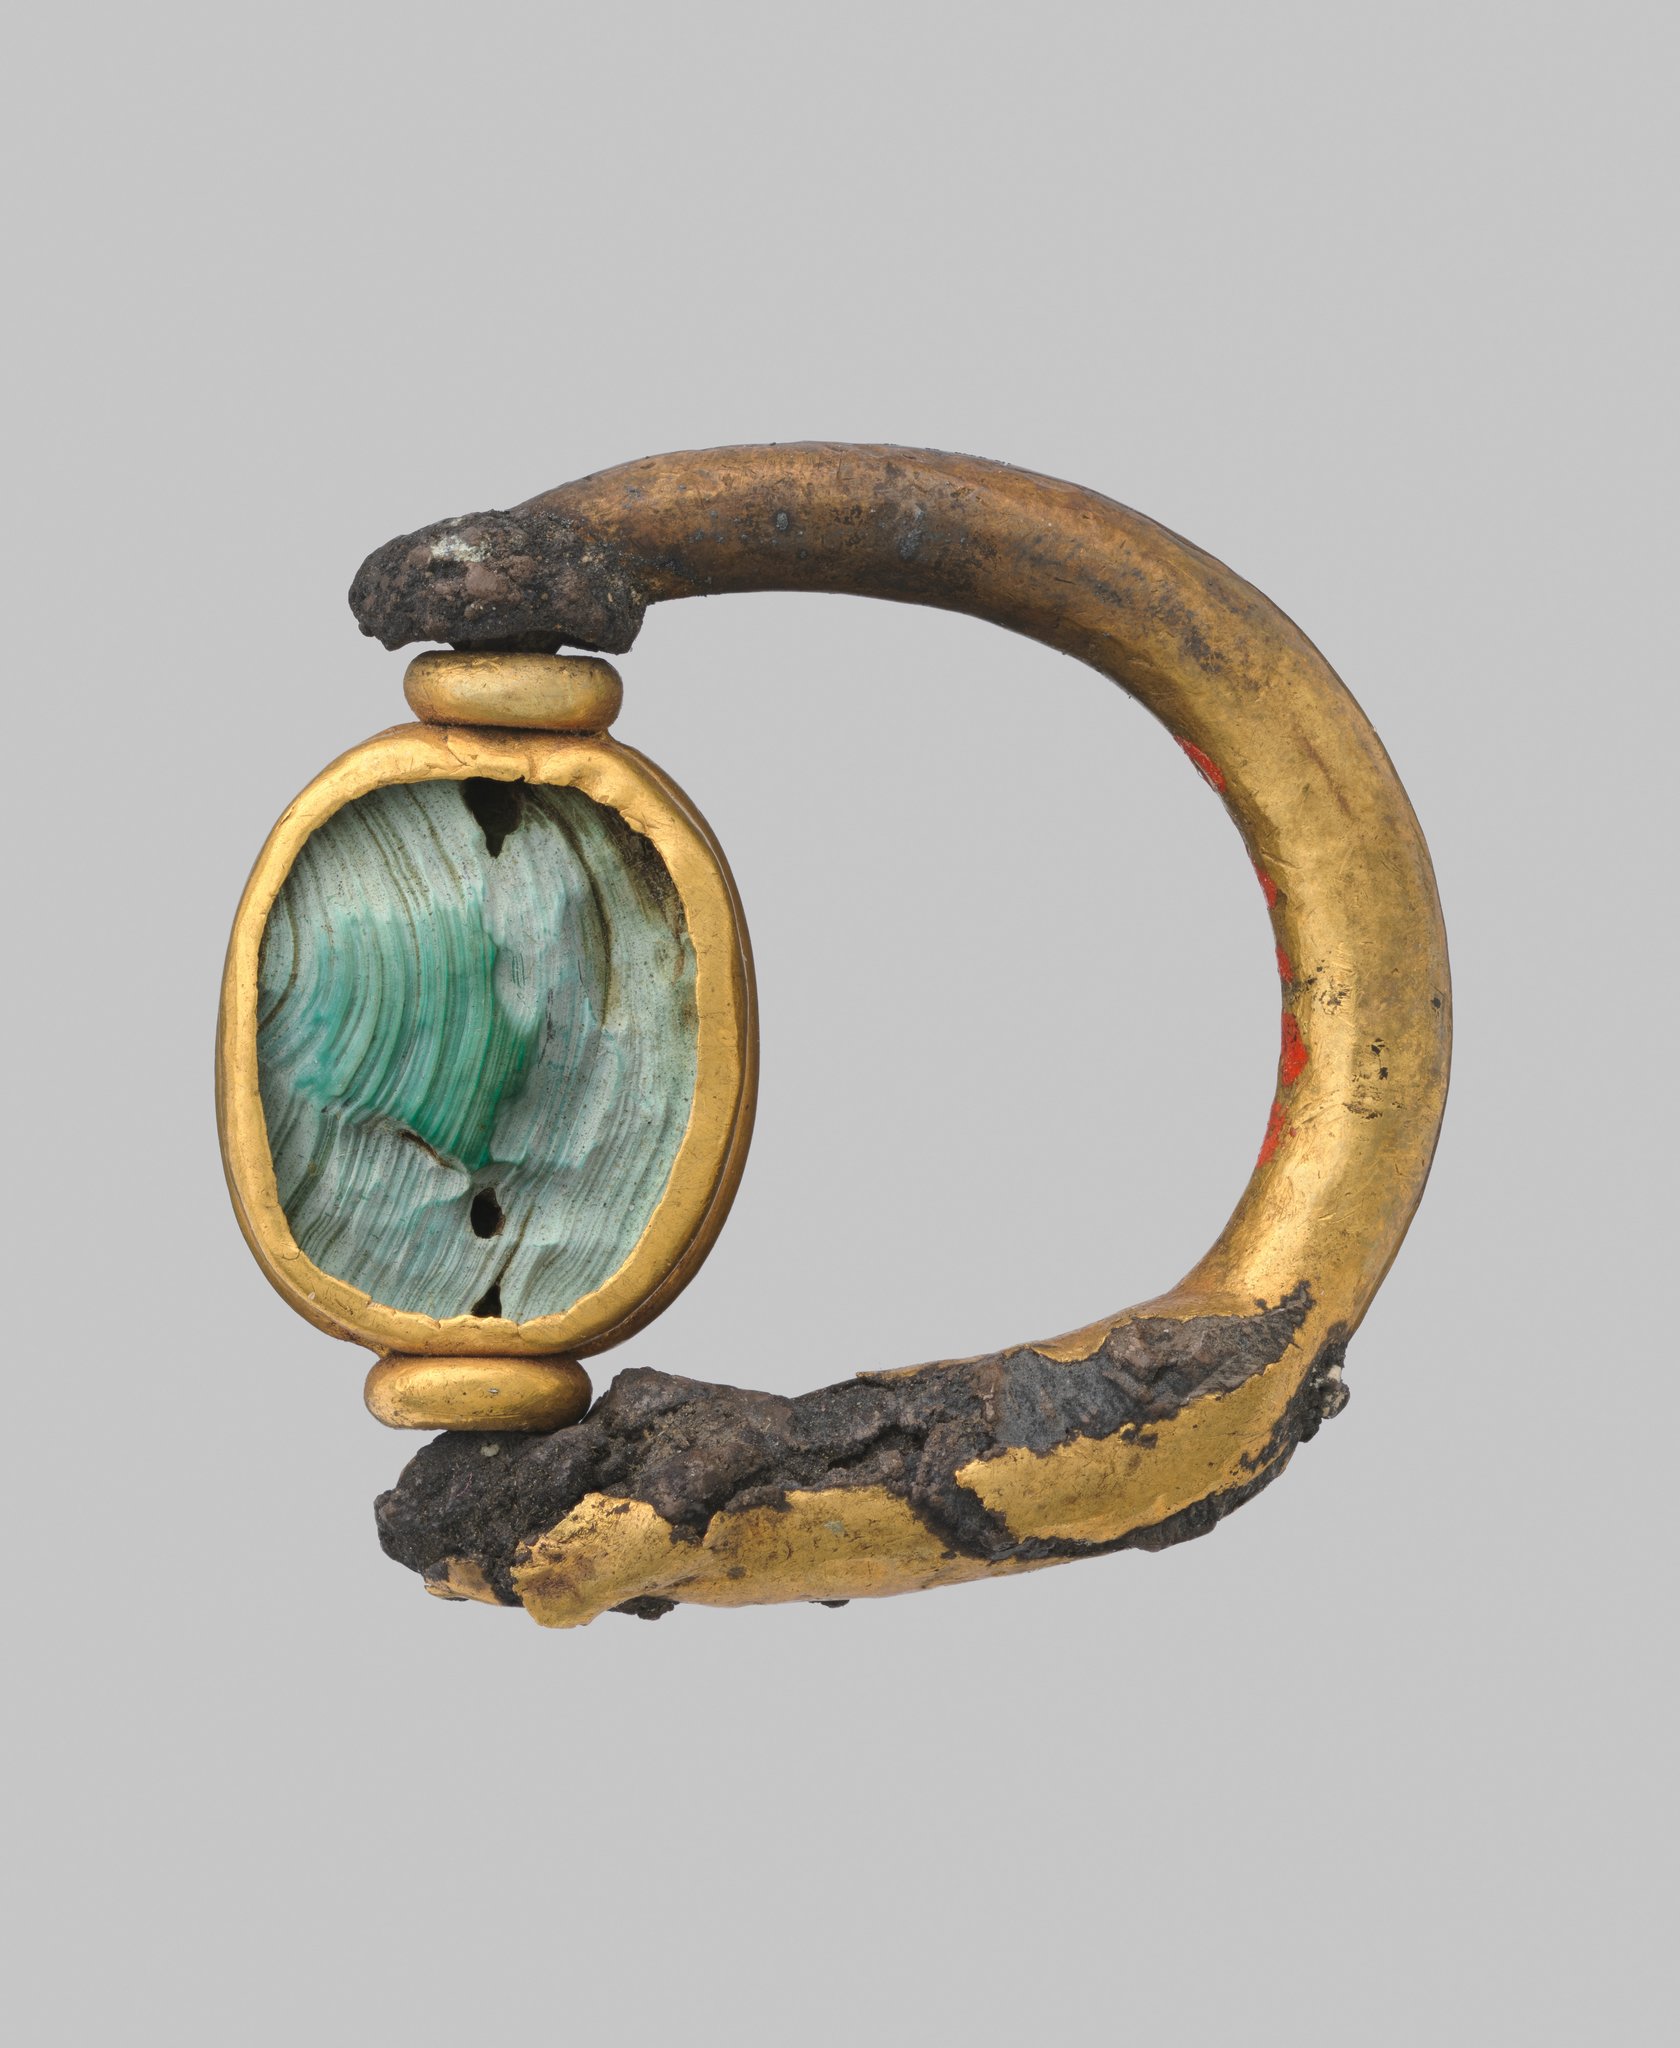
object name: ring with scaraboid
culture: cypriot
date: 700-501 BCE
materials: gold, silver